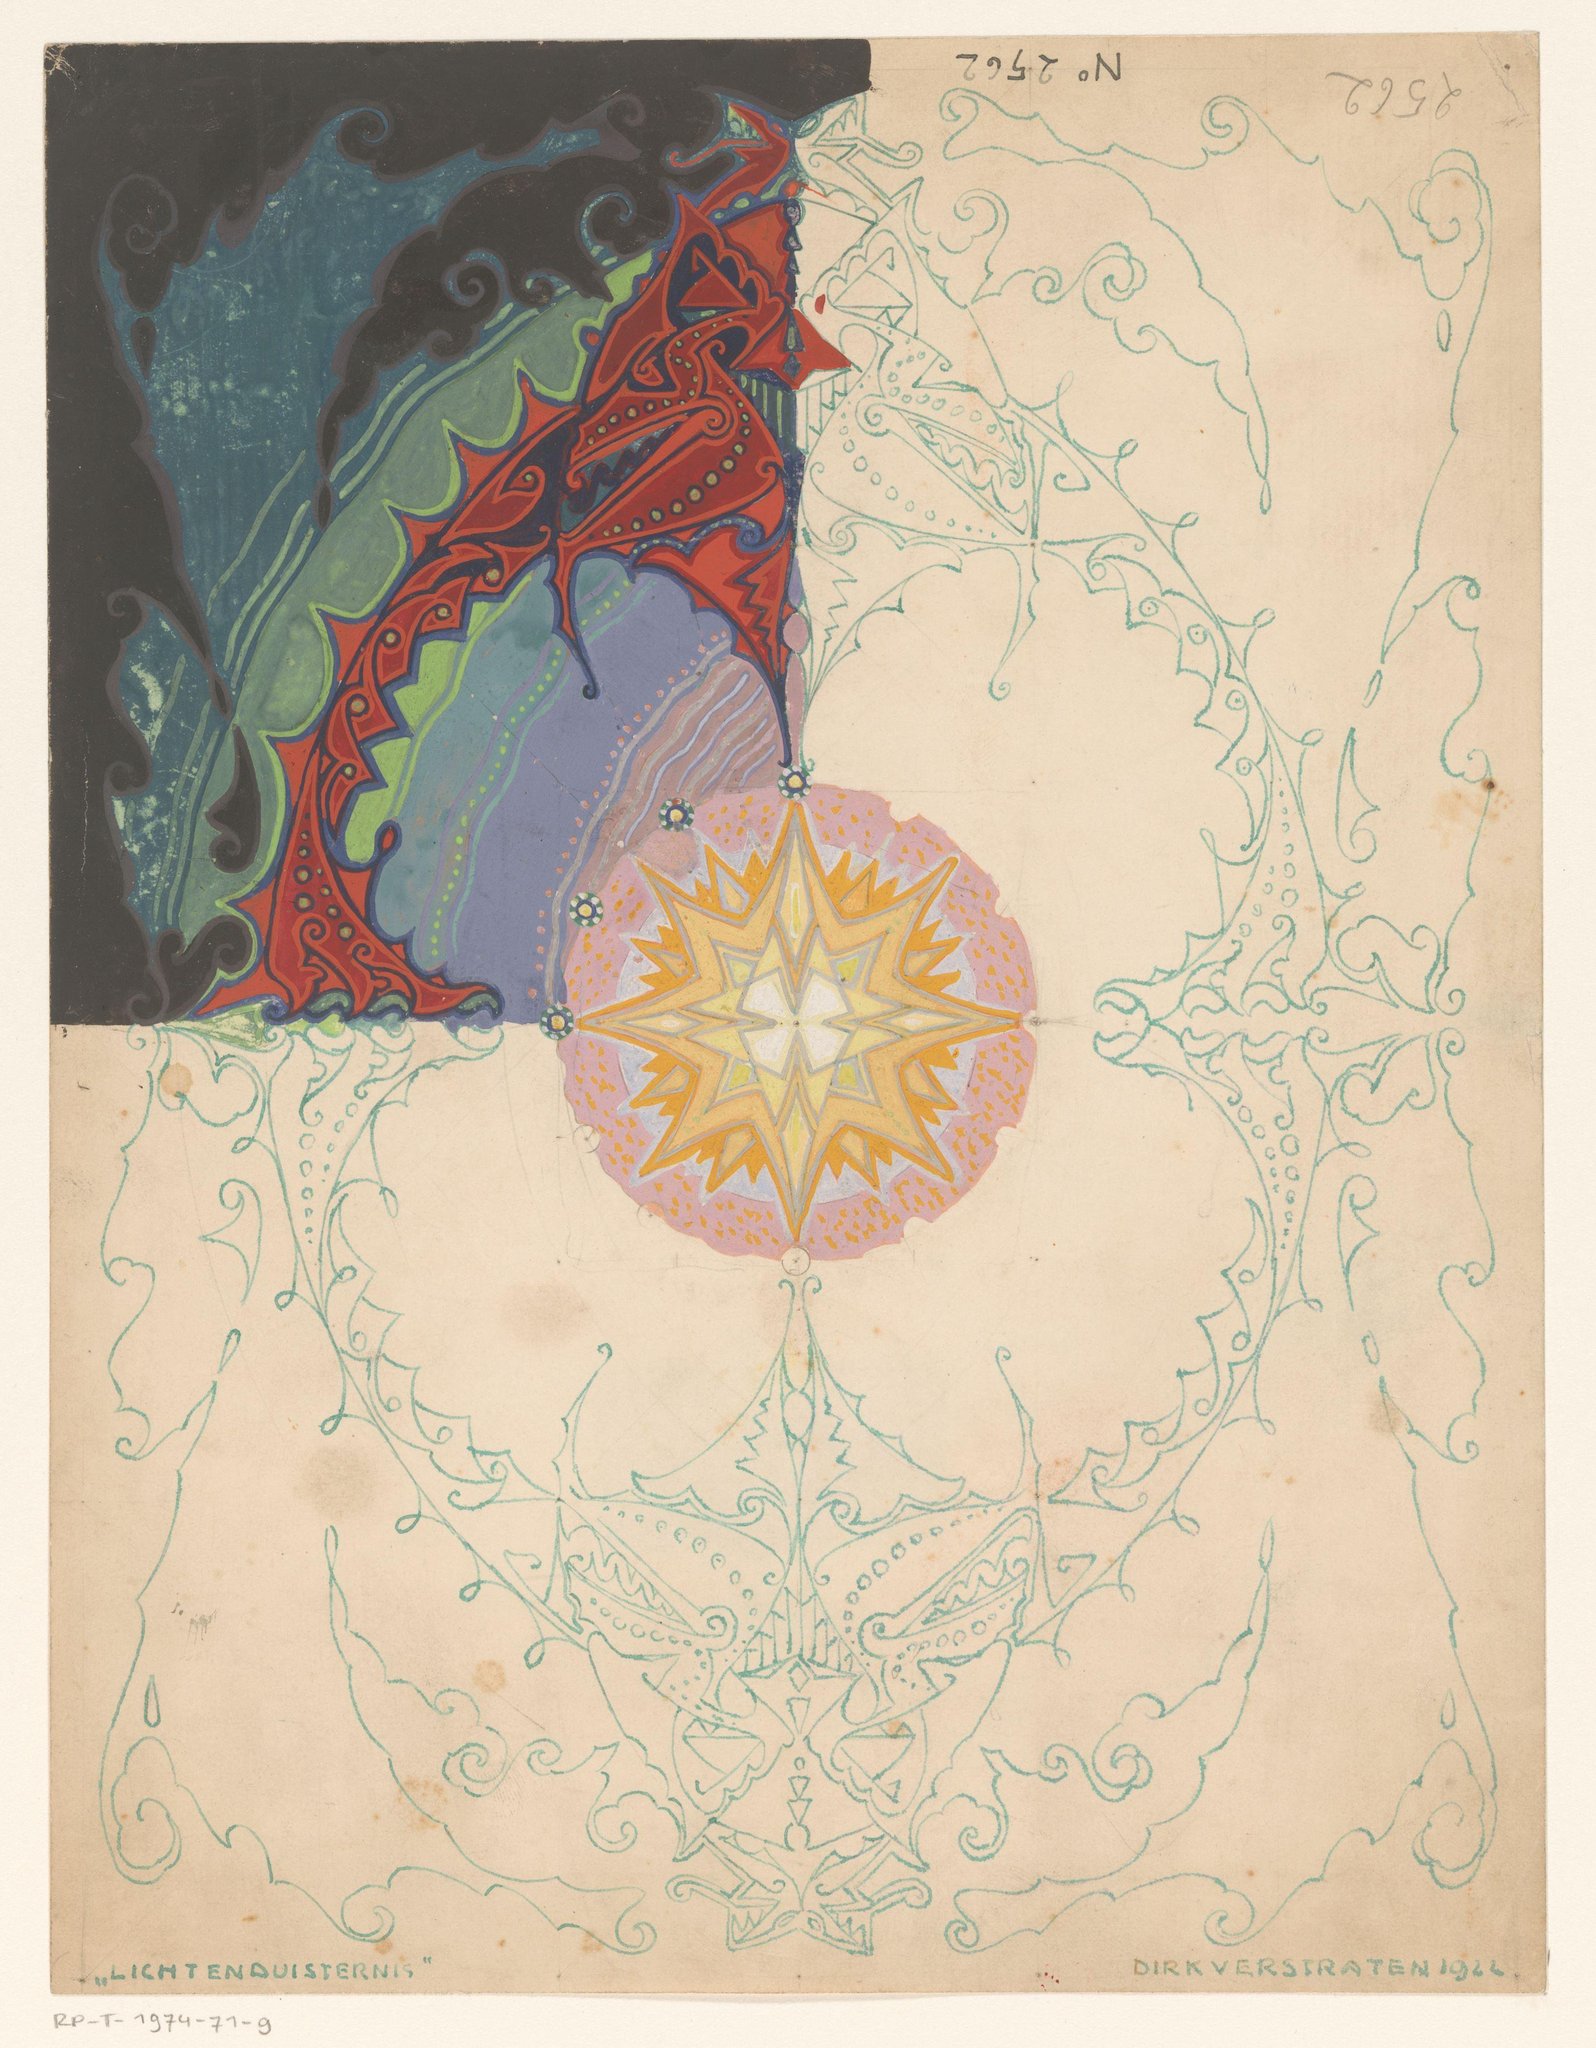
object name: drawing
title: Ontwerp voor een tapijt met een ster in een geornamenteerd ovaal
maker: dirk verstraten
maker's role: designer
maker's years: 1892-1946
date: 1922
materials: paint, ink, paper, pencil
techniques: brush, pen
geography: amsterdam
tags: ornaments ~ art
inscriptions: collector's mark: ‘R:MVS’, number: ‘No 2562’, label: ‘XI.VP./ 2562’